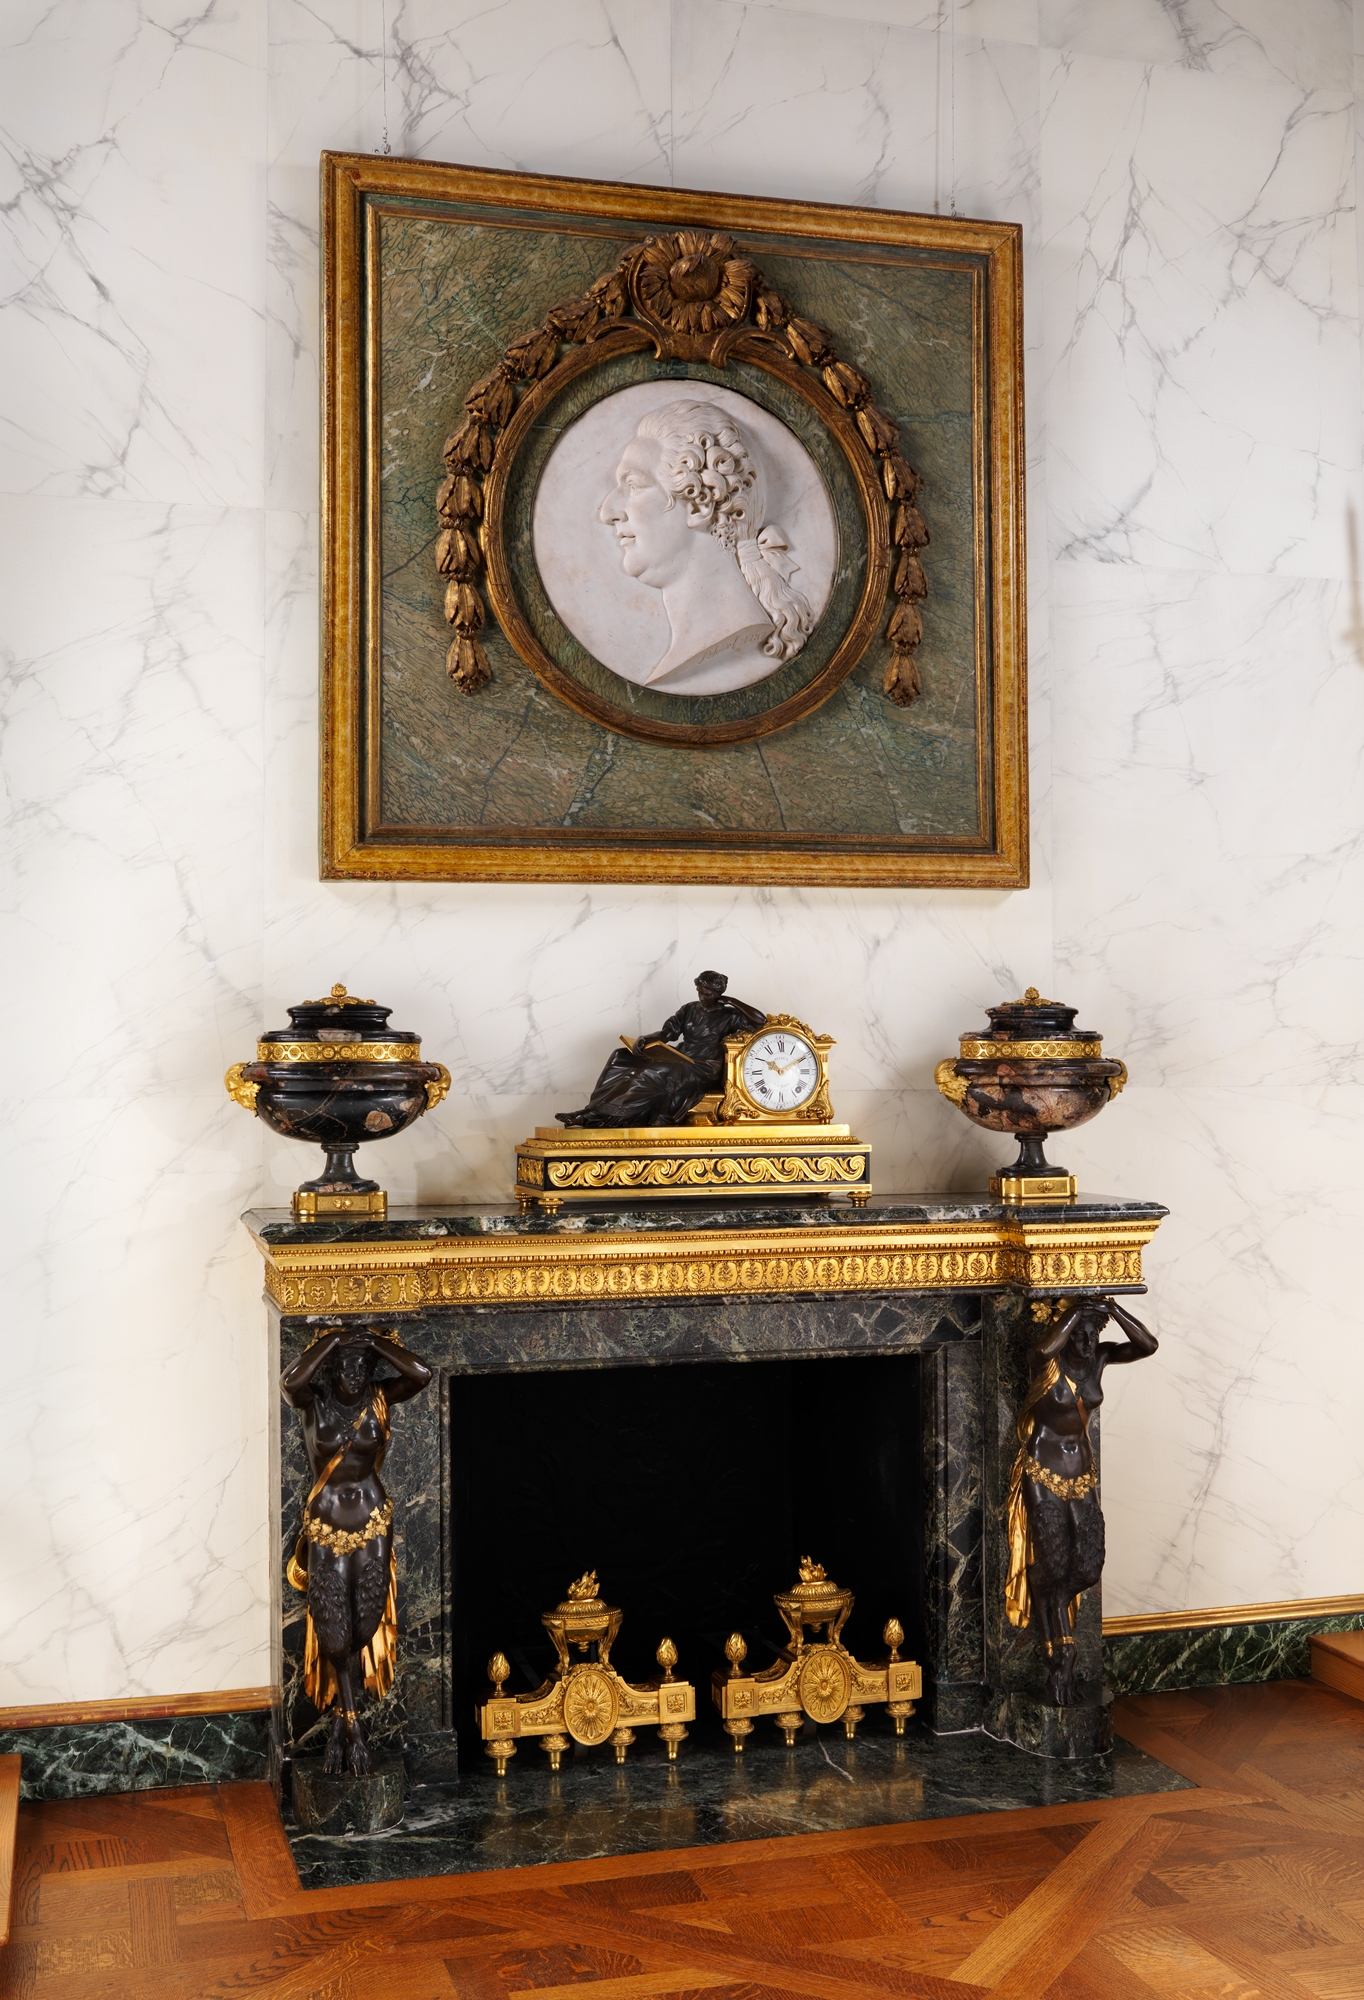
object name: chimneypiece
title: Chimneypiece (cheminée)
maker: françois joseph belanger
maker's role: designer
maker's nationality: french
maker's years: 1744-1818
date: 1784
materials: bronze, gilt bronze, marble